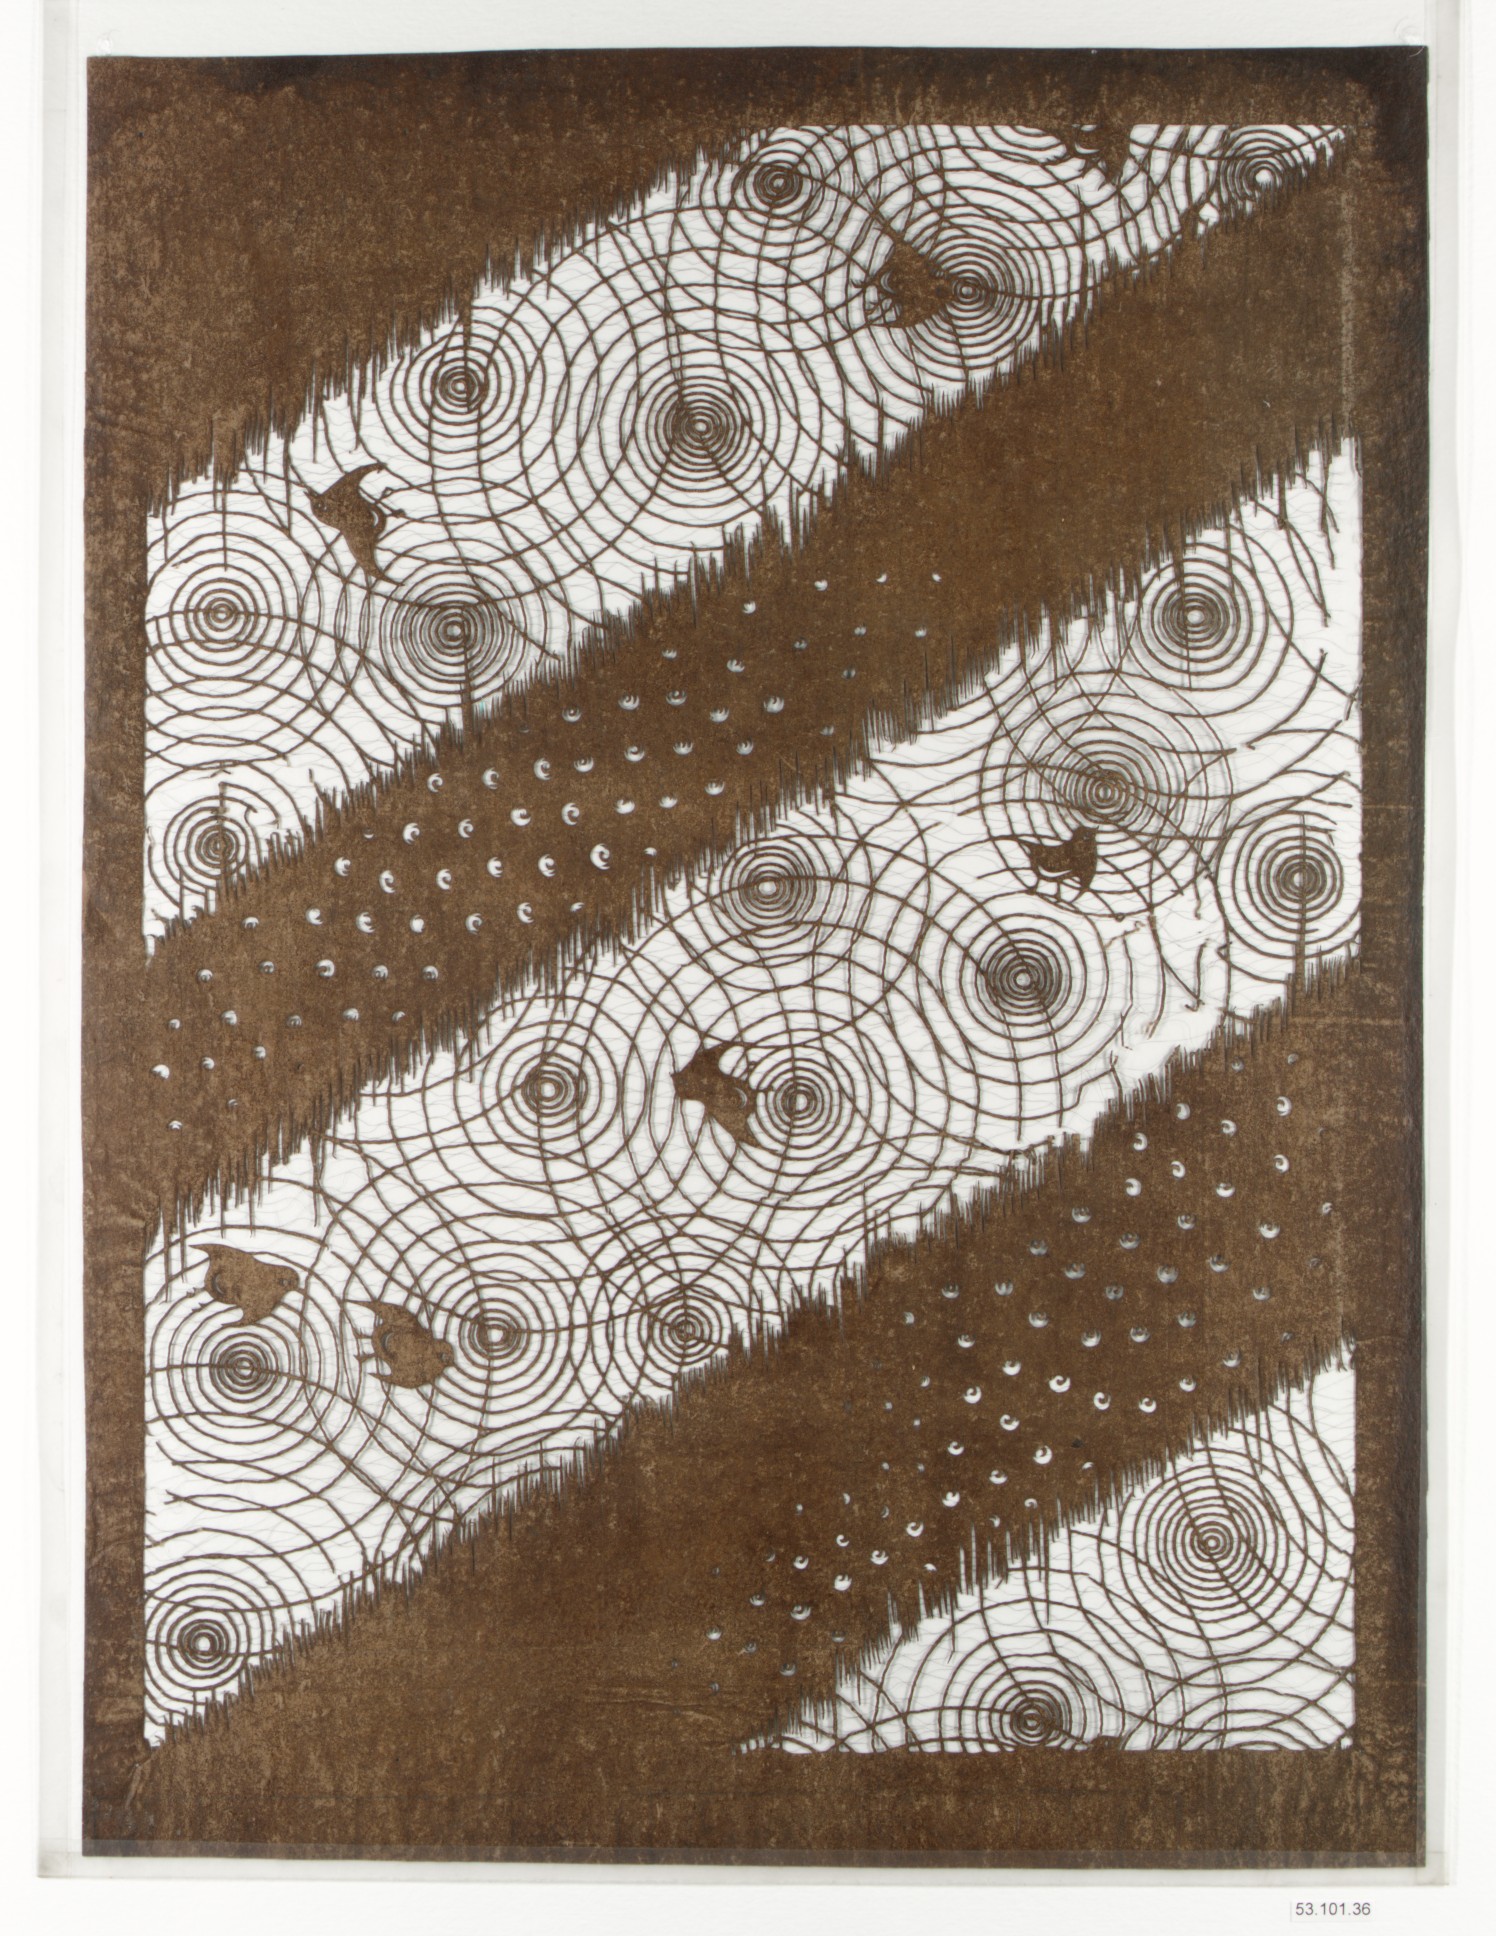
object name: stencil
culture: japanese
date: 1615-1868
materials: paper